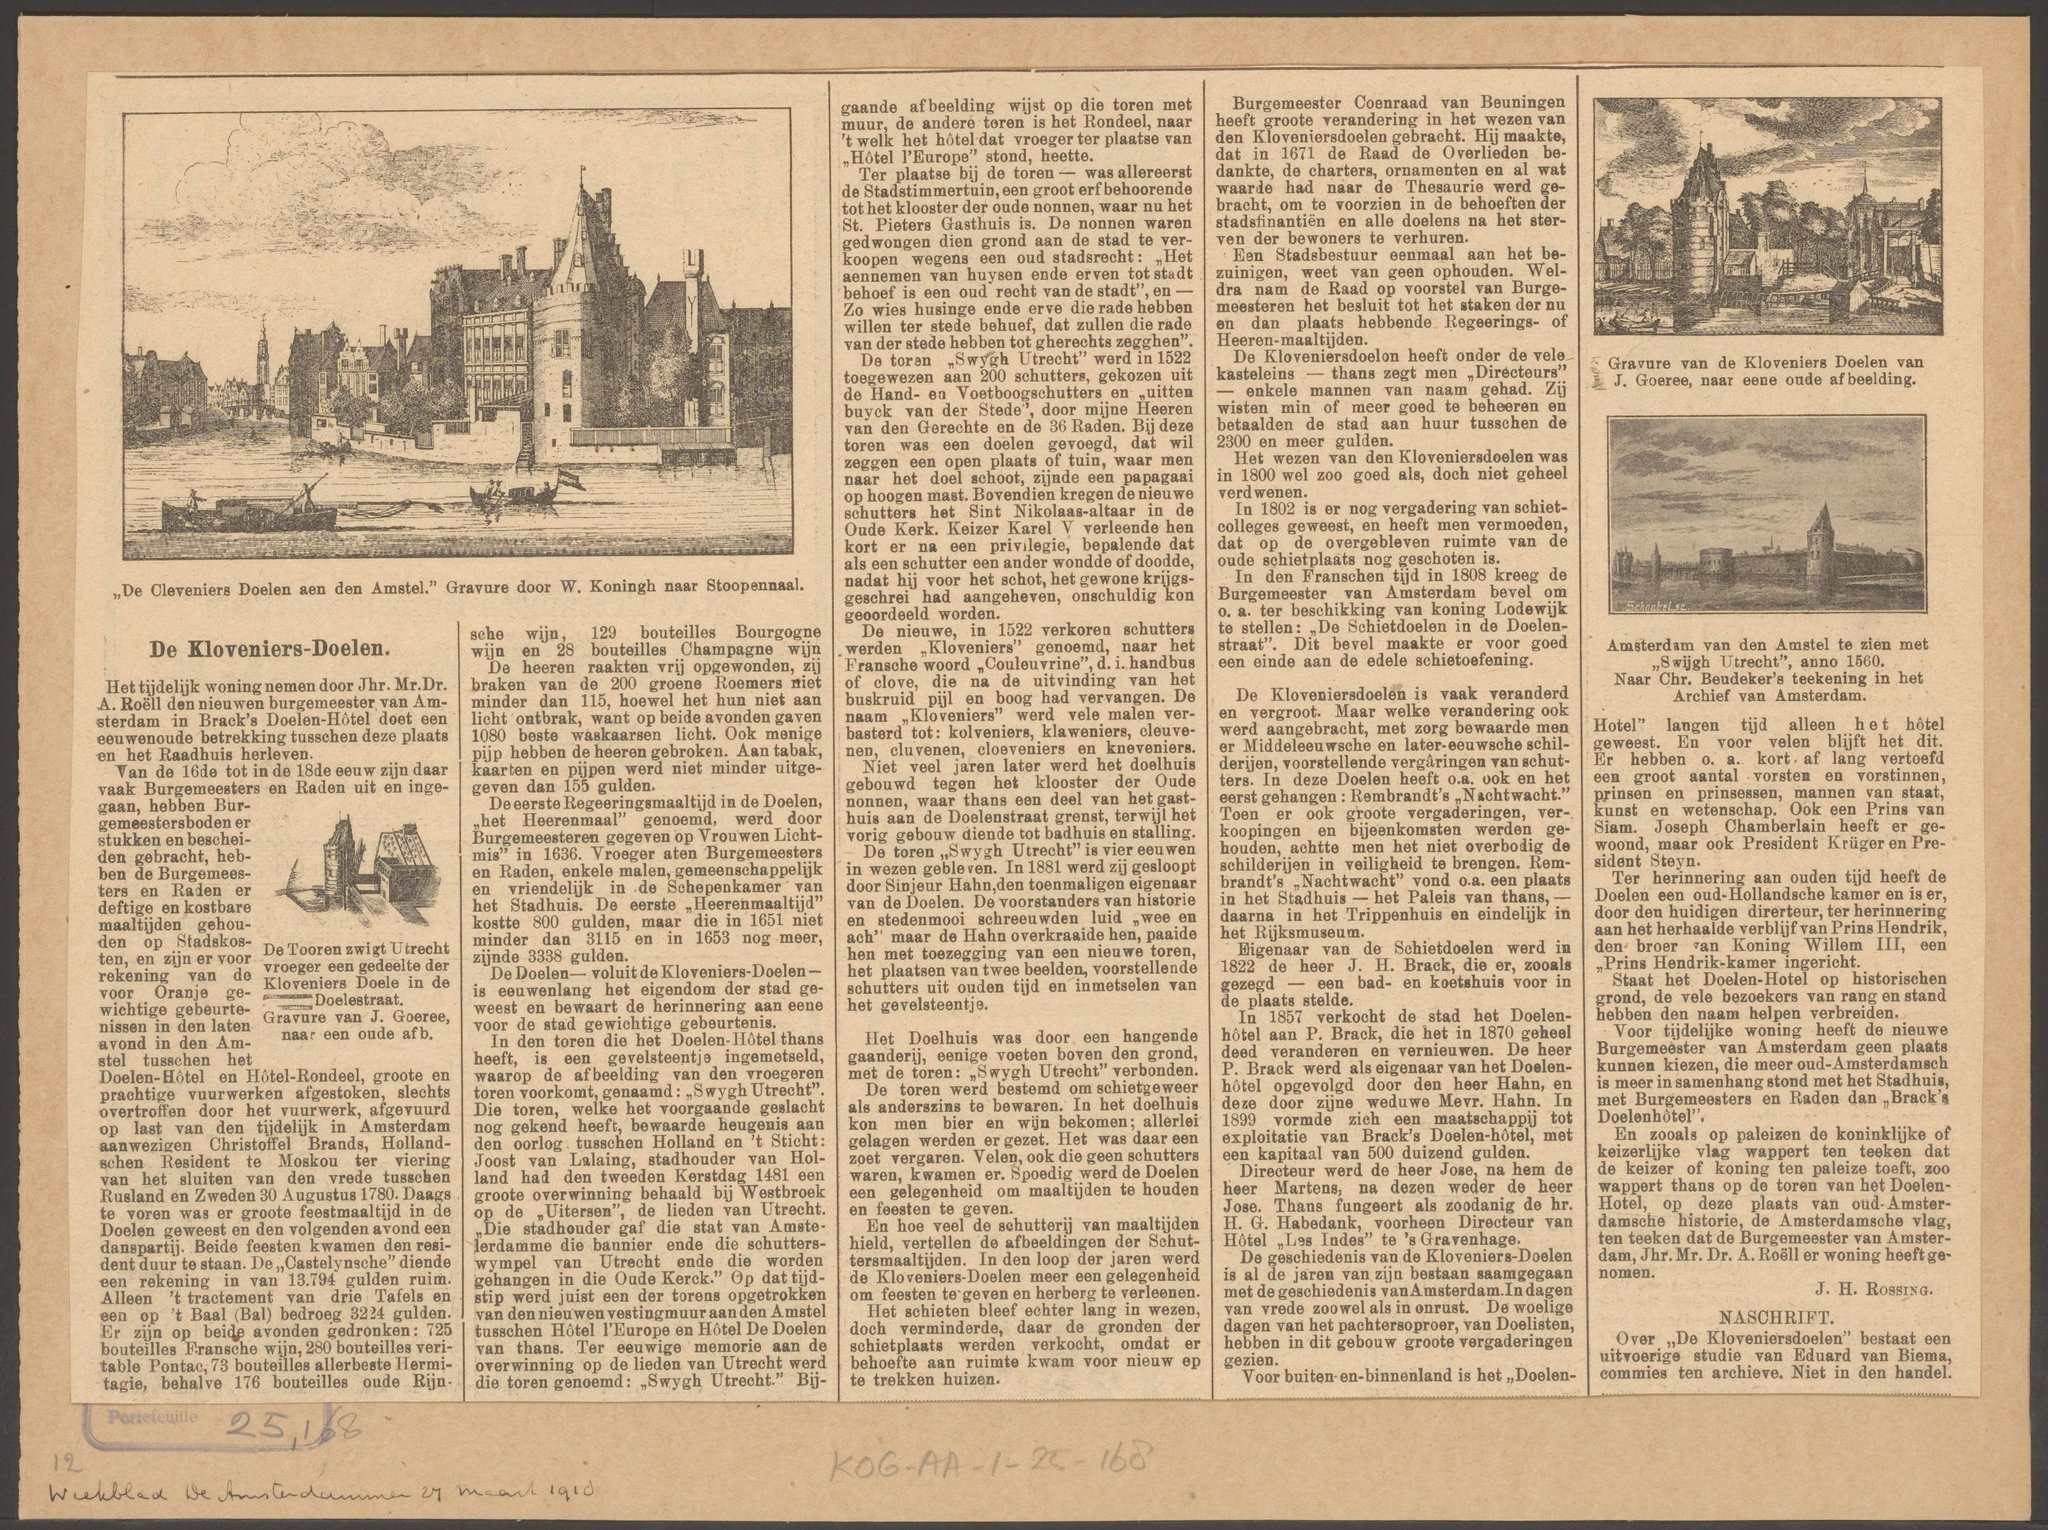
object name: photomechanical print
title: Kloveniersdoelen te Amsterdam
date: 1910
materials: paper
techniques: letterpress printing, line block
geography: northern netherlands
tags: canals, waters (in city), tower (of house or building)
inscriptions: collector's mark: ‘25.168’ Lugt 1641b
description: Knipsel uit pagina 7 uit Weekblad De Amsterdammer (1910) met 4 prenten. Onderwerpsrubriek binnen de Atlas Amsterdam: Krijgswezen I: De Admiraliteit van Amsterdam, E. Doelen en Wachthuizen.